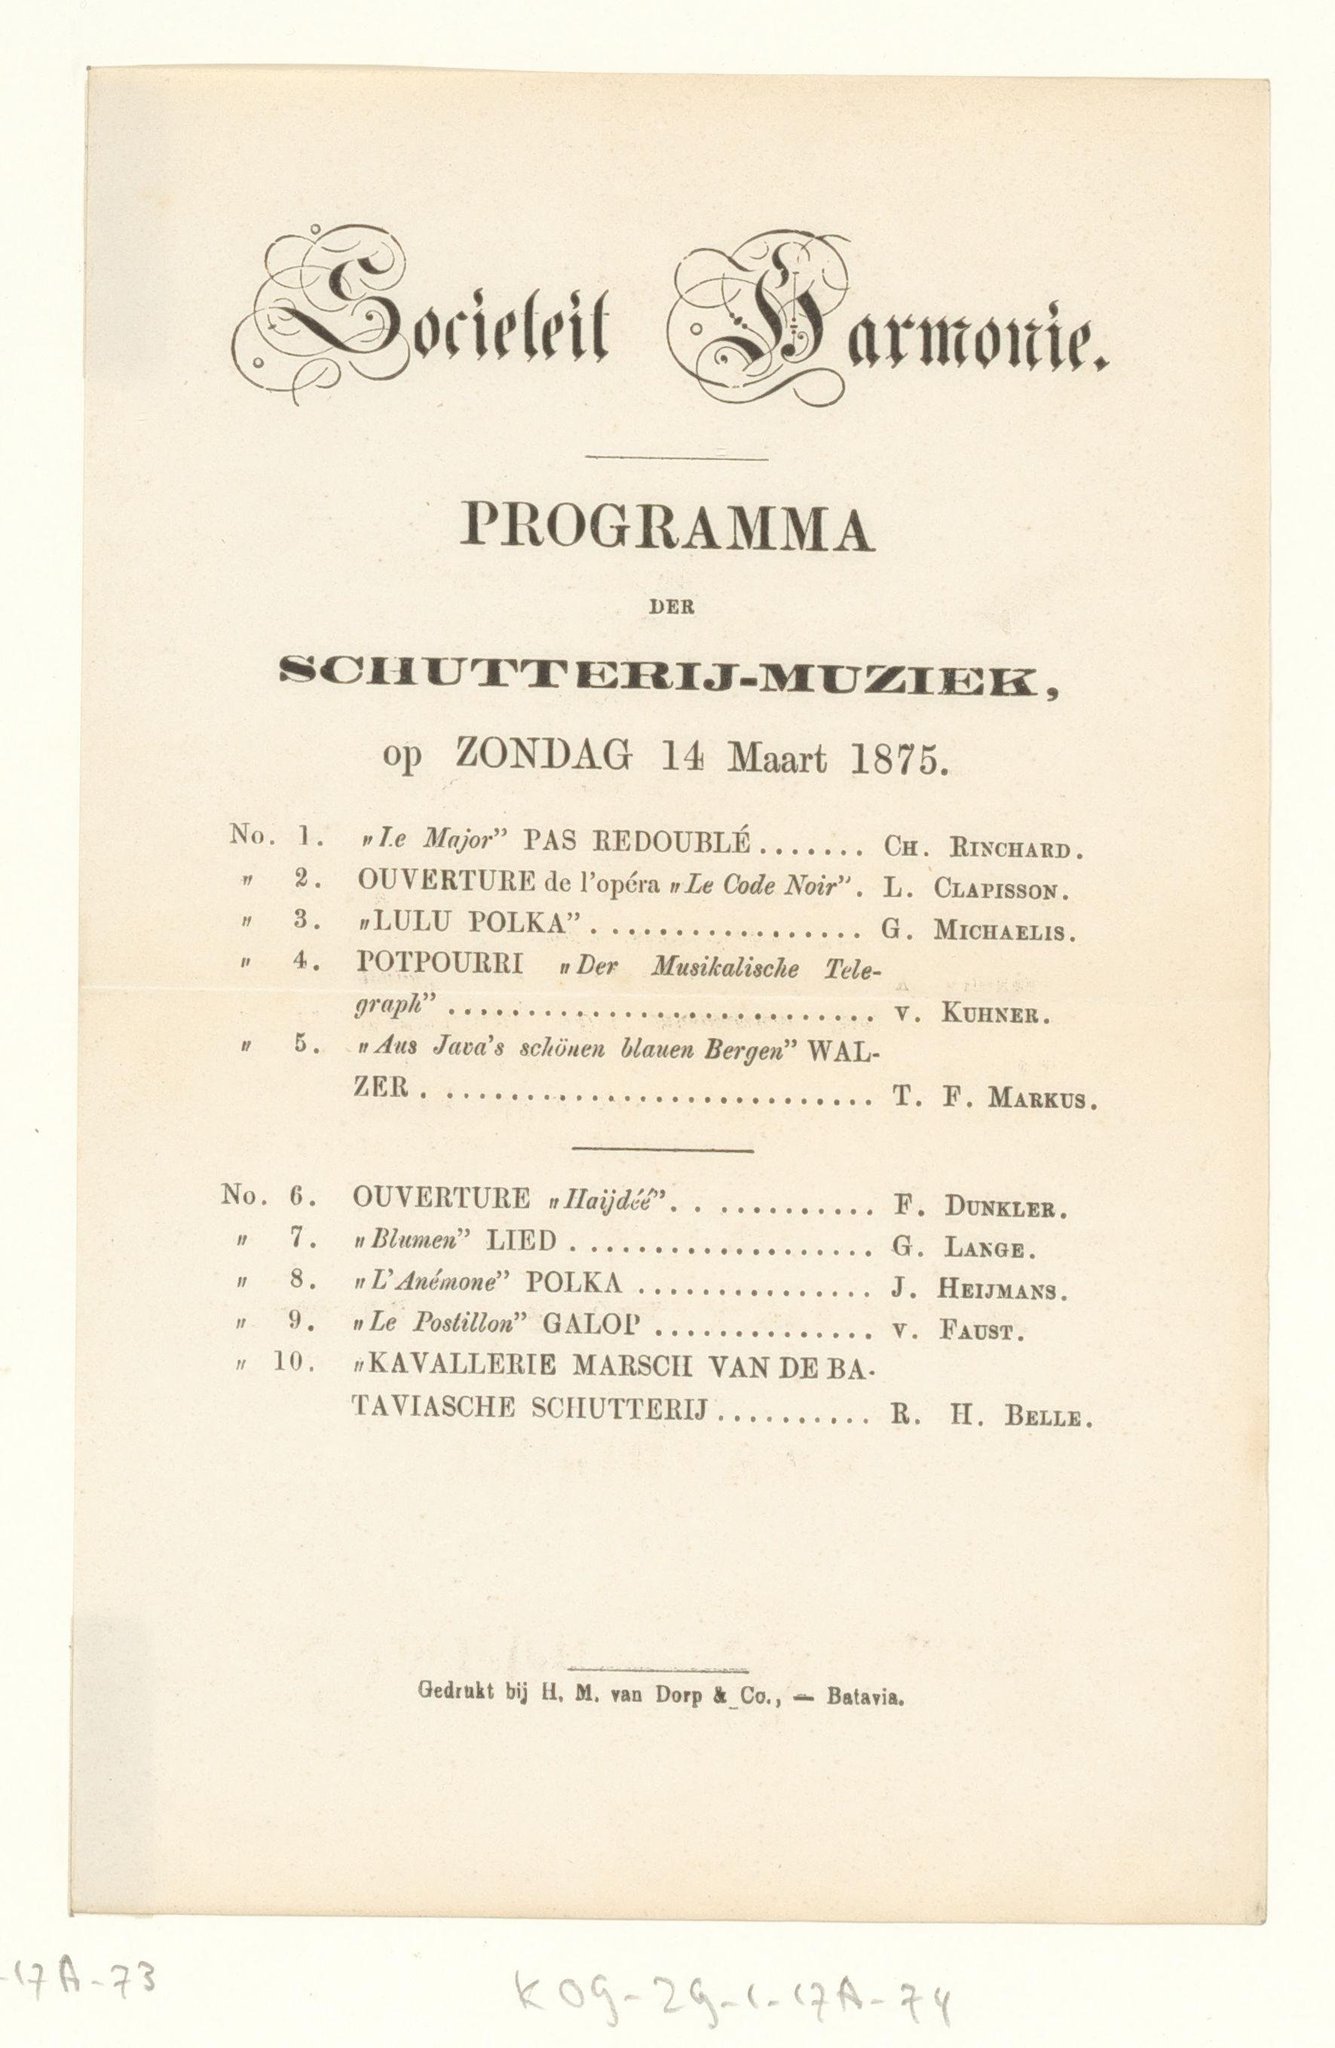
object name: text sheet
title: Programma voor een concert in Sociëteit Harmonie op 14 maart 1875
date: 1875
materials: paper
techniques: letterpress printing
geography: batavia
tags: listening to music, large group of musicians, orchestra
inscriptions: collector's mark: Lugt 1641, collector's mark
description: Gedrukt programma voor een concert van schutterijmuziek in de Sociëteit Harmonie te Batavia op 14 maart 1875. Onderwerpsrubrieken binnen de Atlas Zeden en Gewoonten: Muziek en muziekinstrumenten: Varia.